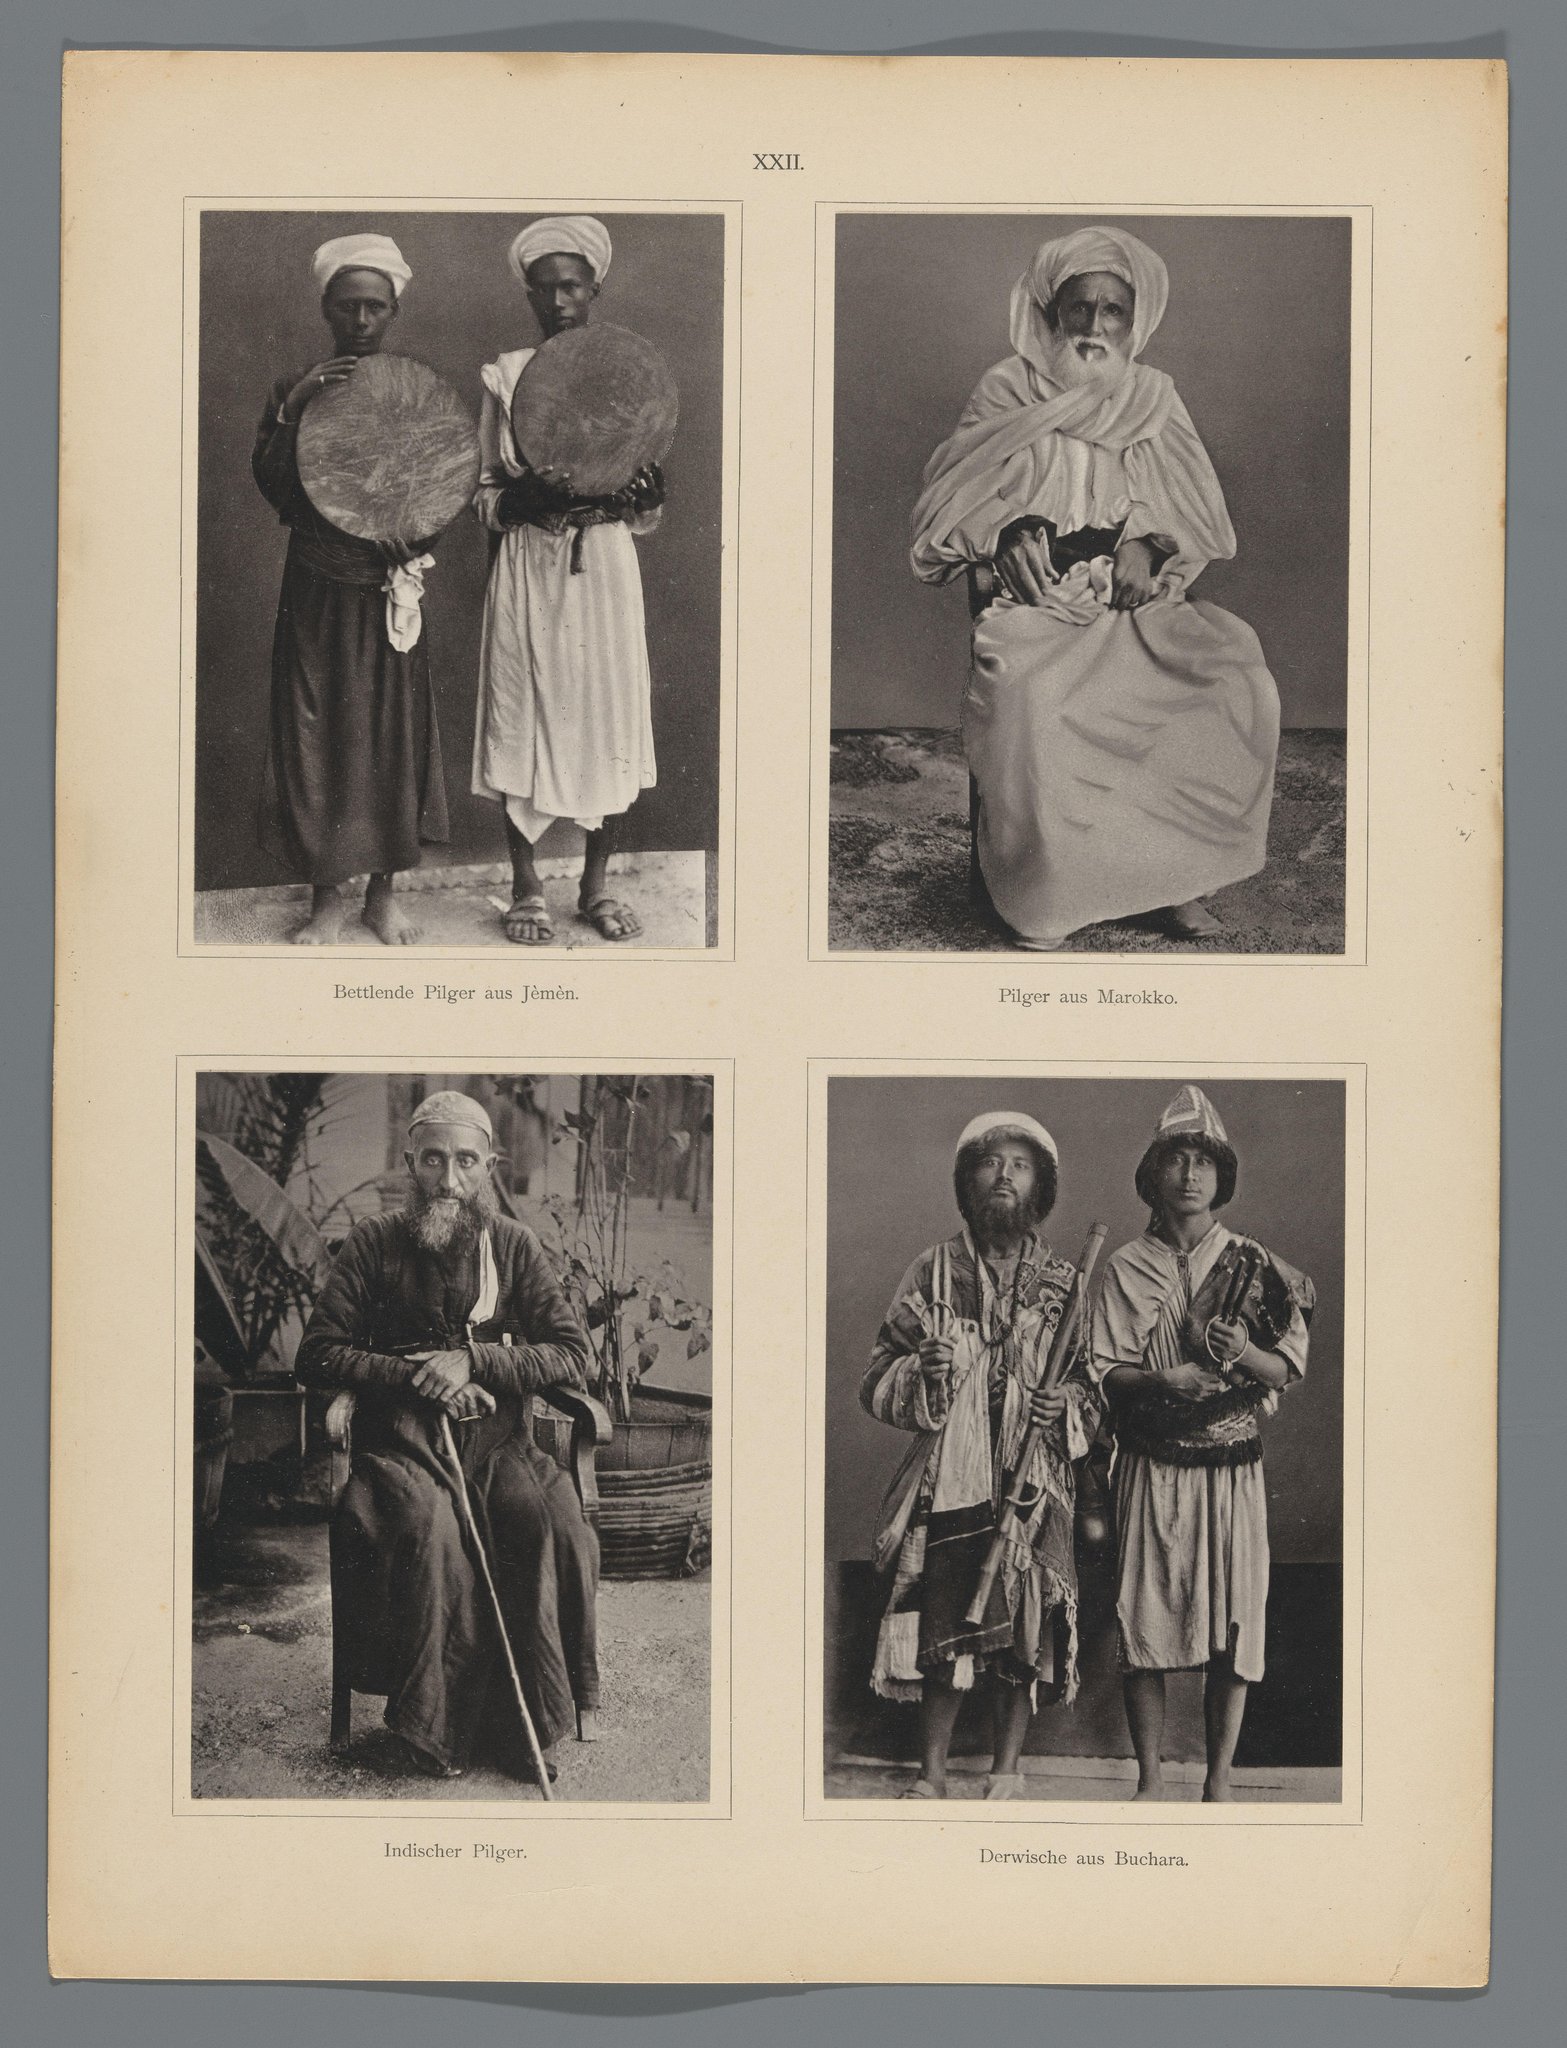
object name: page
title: Vier portretten van pelgrims en derwisjen, te Djedda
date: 1884-1888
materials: paper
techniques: photograph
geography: djedda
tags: the believer ~ islam, mohammedanism, anonymous historical person portrayed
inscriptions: number: ‘XXII.’